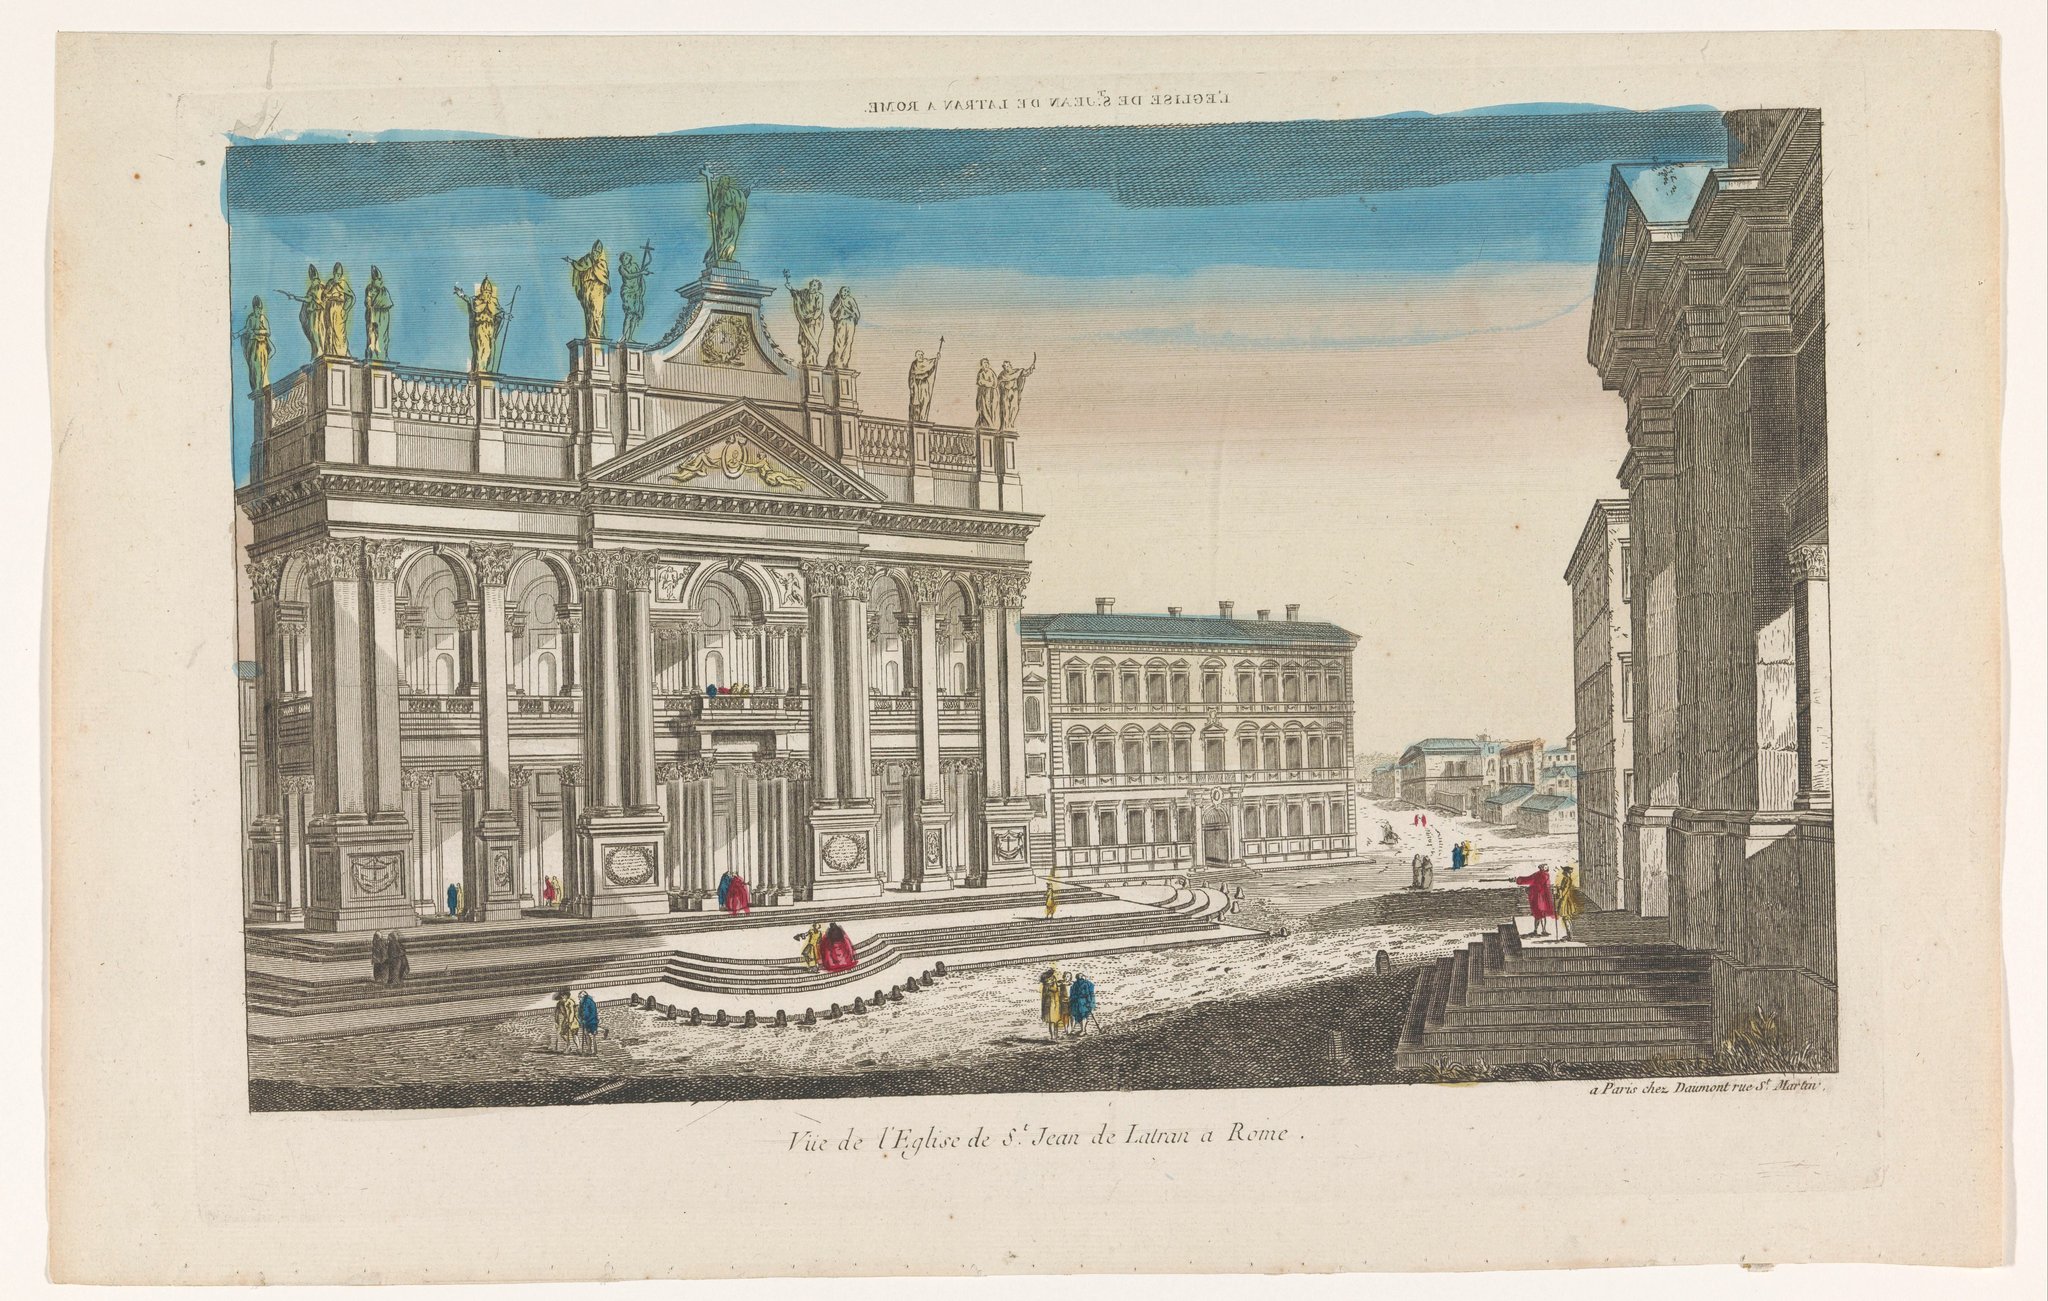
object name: print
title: Gezicht op de kerk Sint-Jan van Lateranen te Rome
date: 1745-1775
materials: paper, watercolor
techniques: brush, etching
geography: france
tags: church (exterior), street (+ city(-scape) with figures, staffage)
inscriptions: collector's mark: Lugt 2166